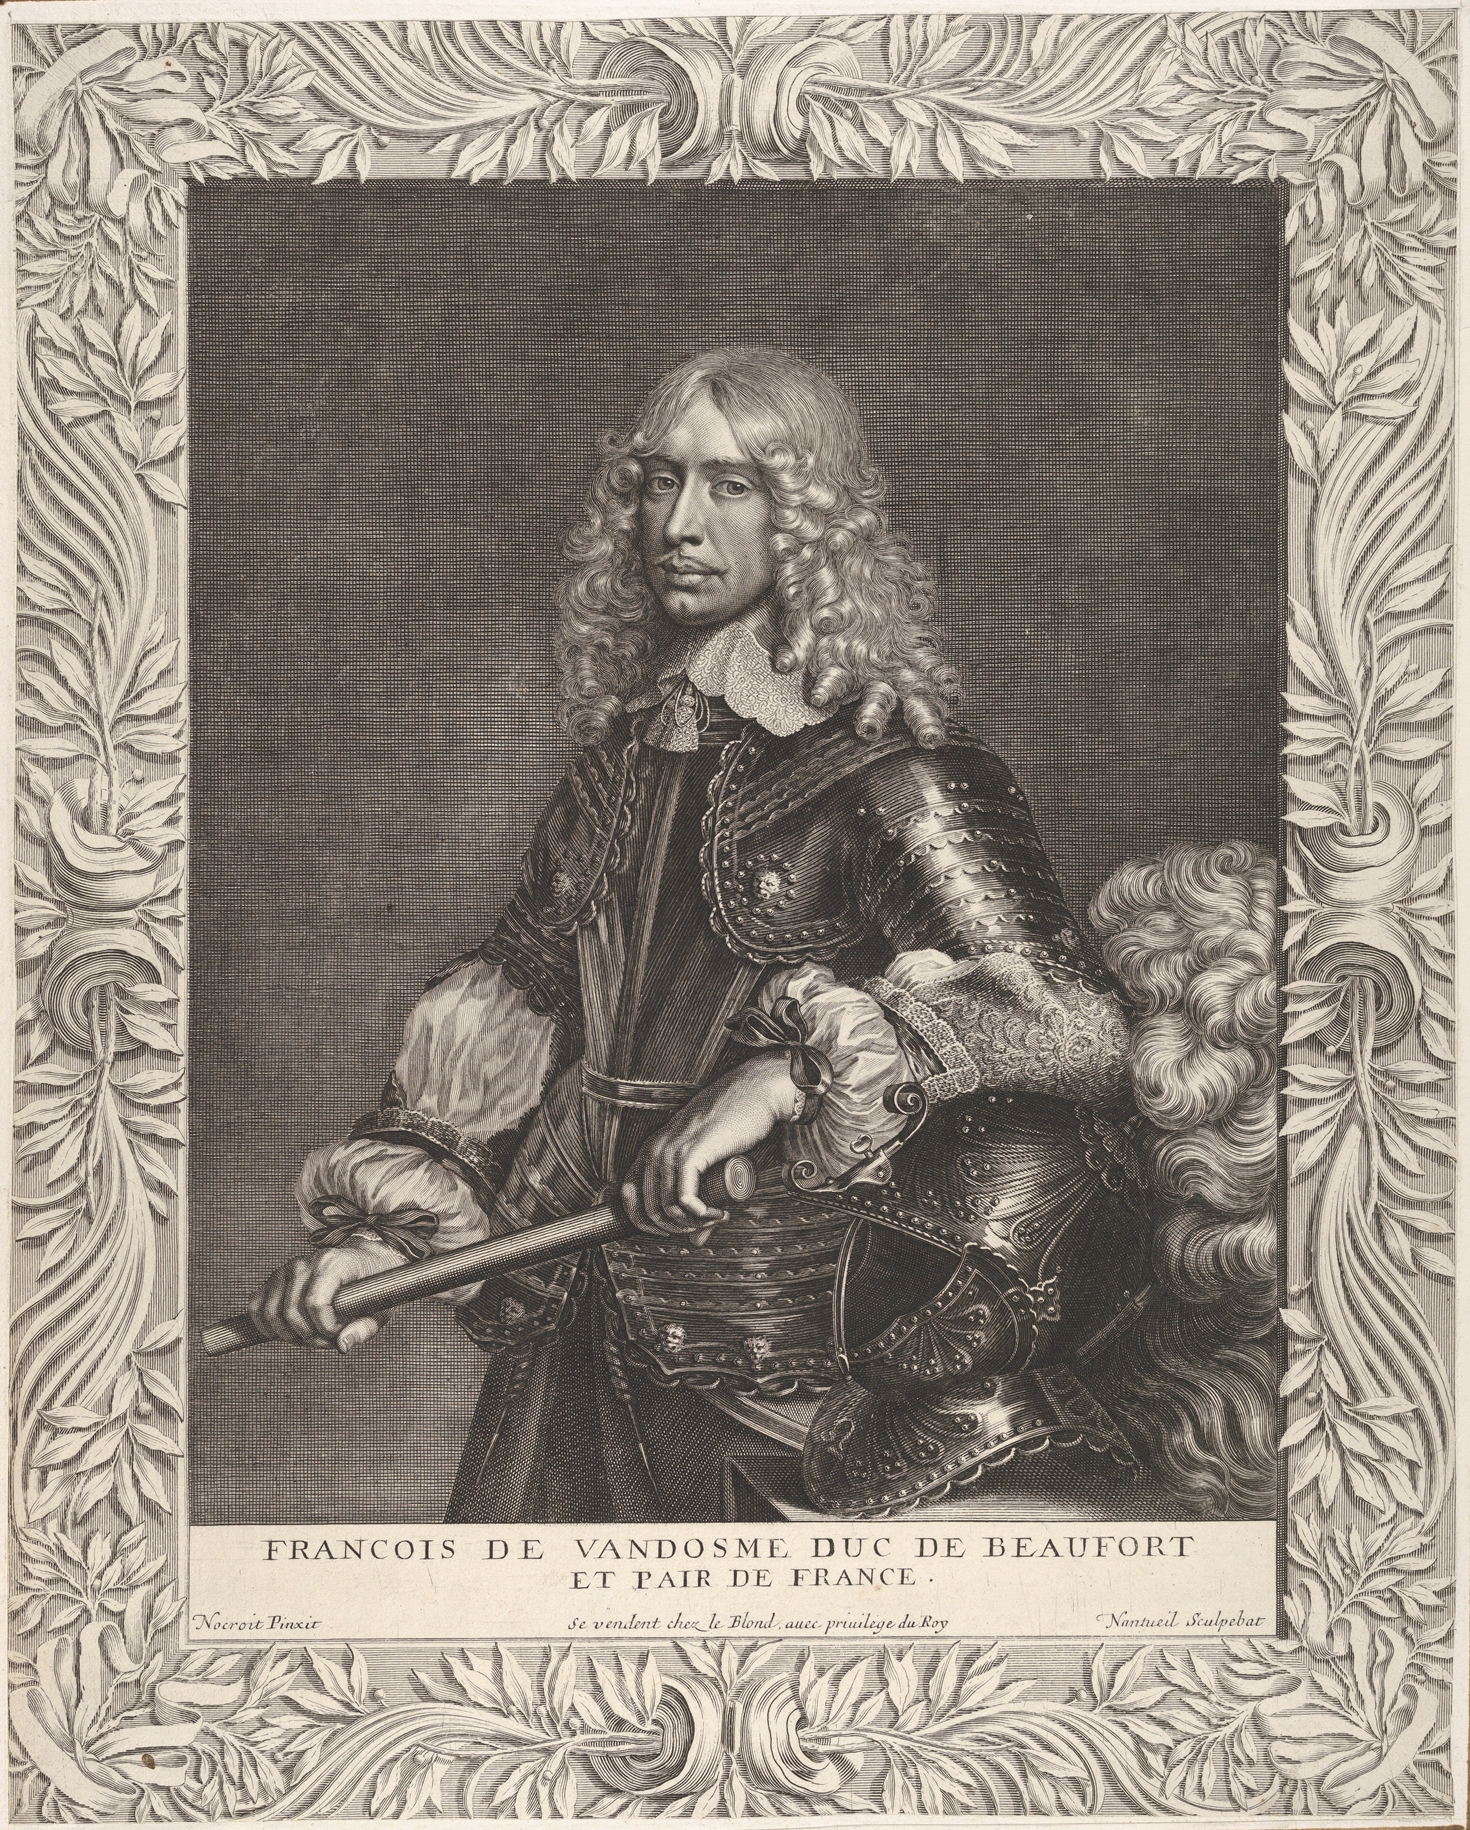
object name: print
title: François de Vendôme, duc de Beaufort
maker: robert nanteuil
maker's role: artist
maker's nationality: french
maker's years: 1623-1678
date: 1649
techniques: engraving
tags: men,portraits